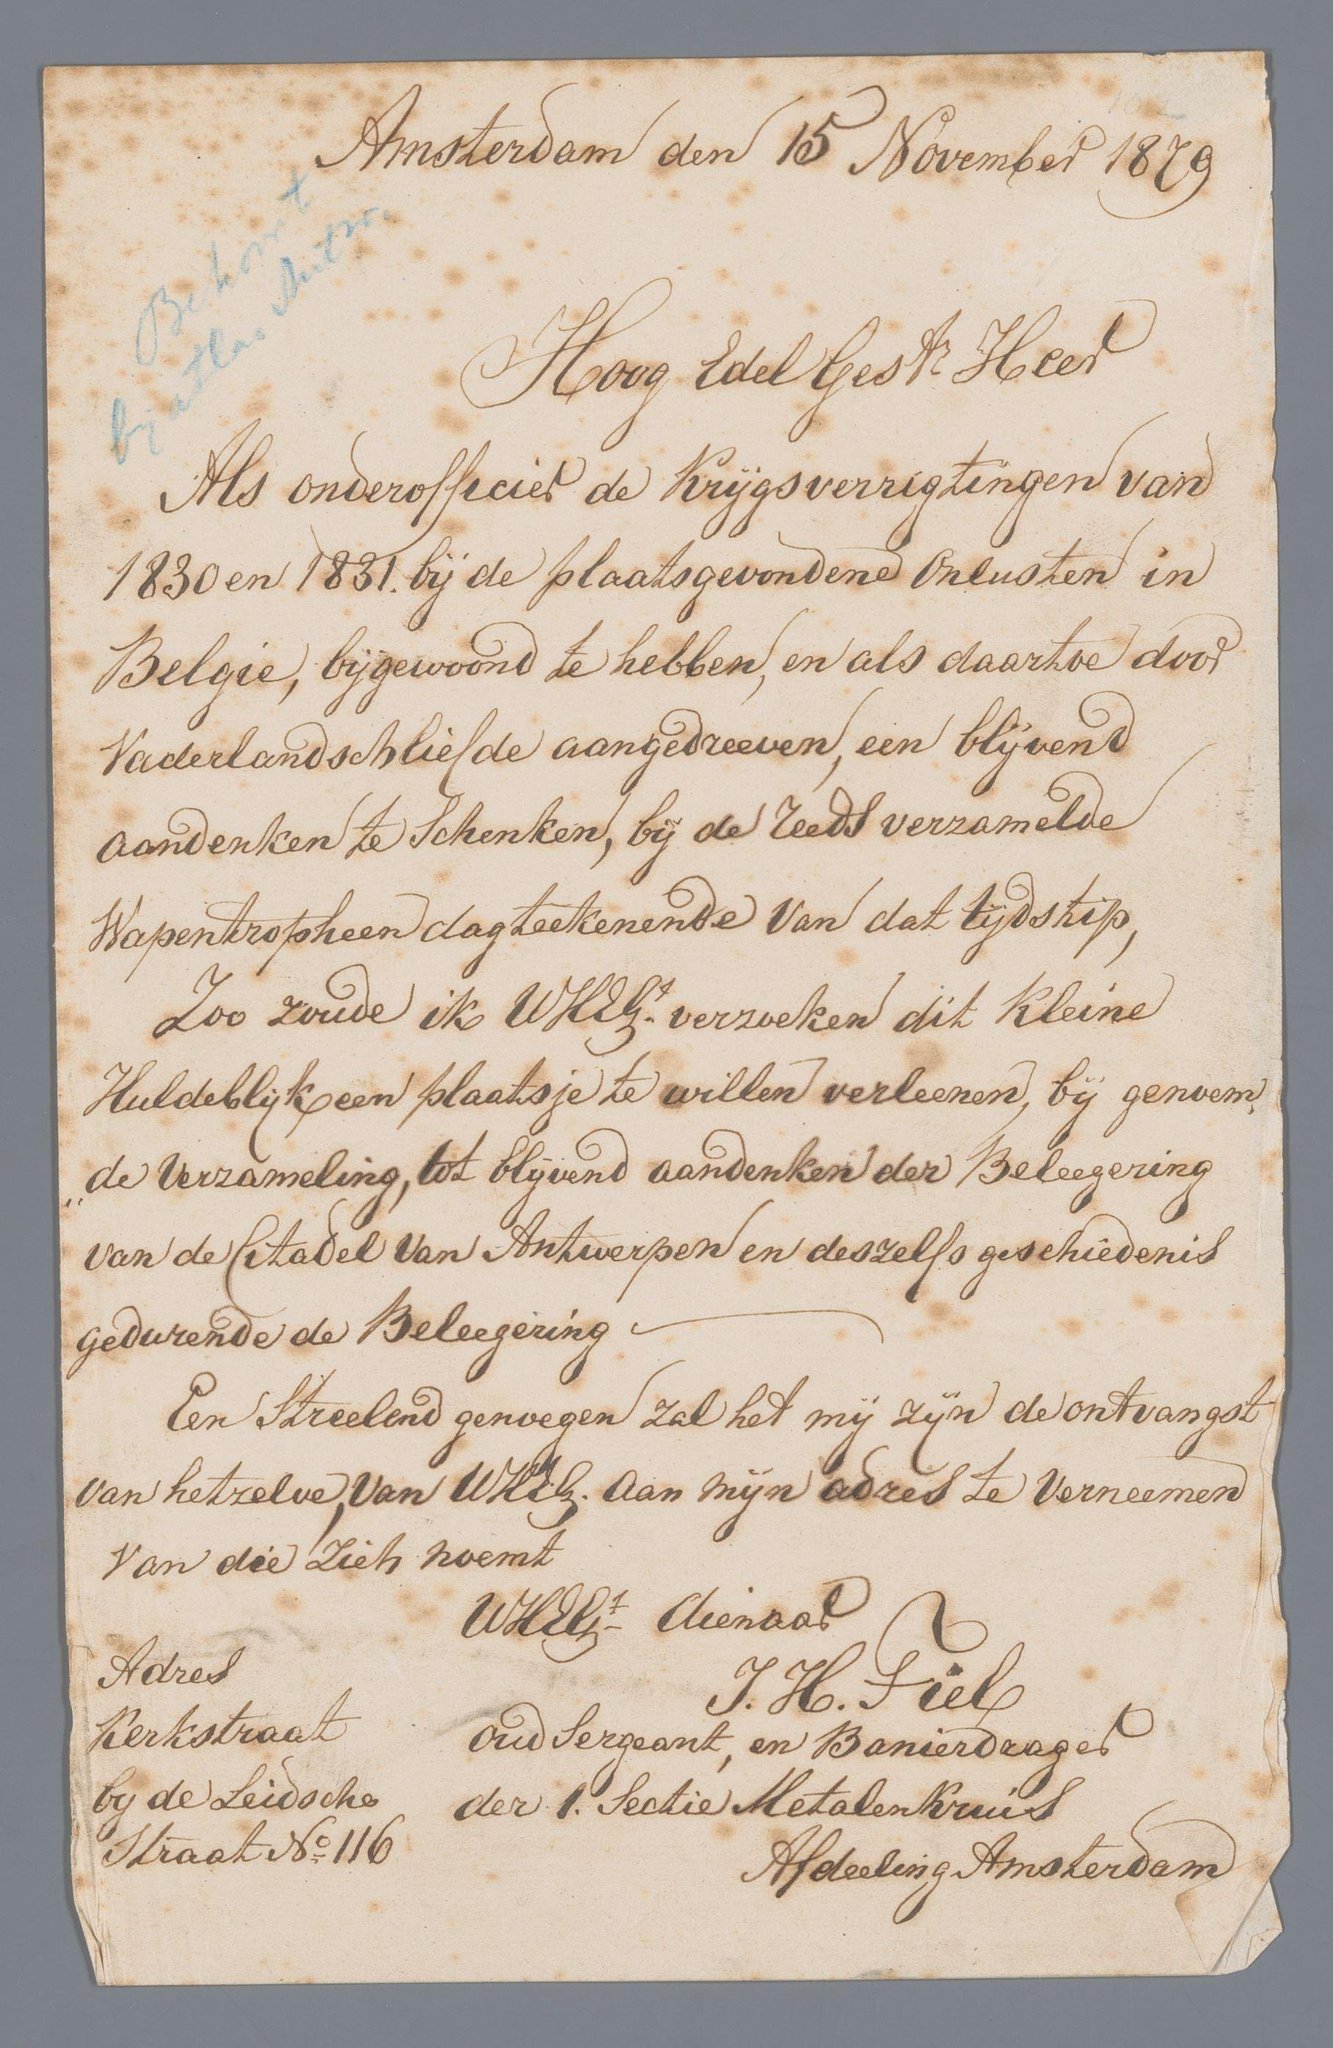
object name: letter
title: Brief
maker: j.h. tiel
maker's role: schrijver, sergeant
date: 1879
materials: ink, paper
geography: amsterdam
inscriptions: date